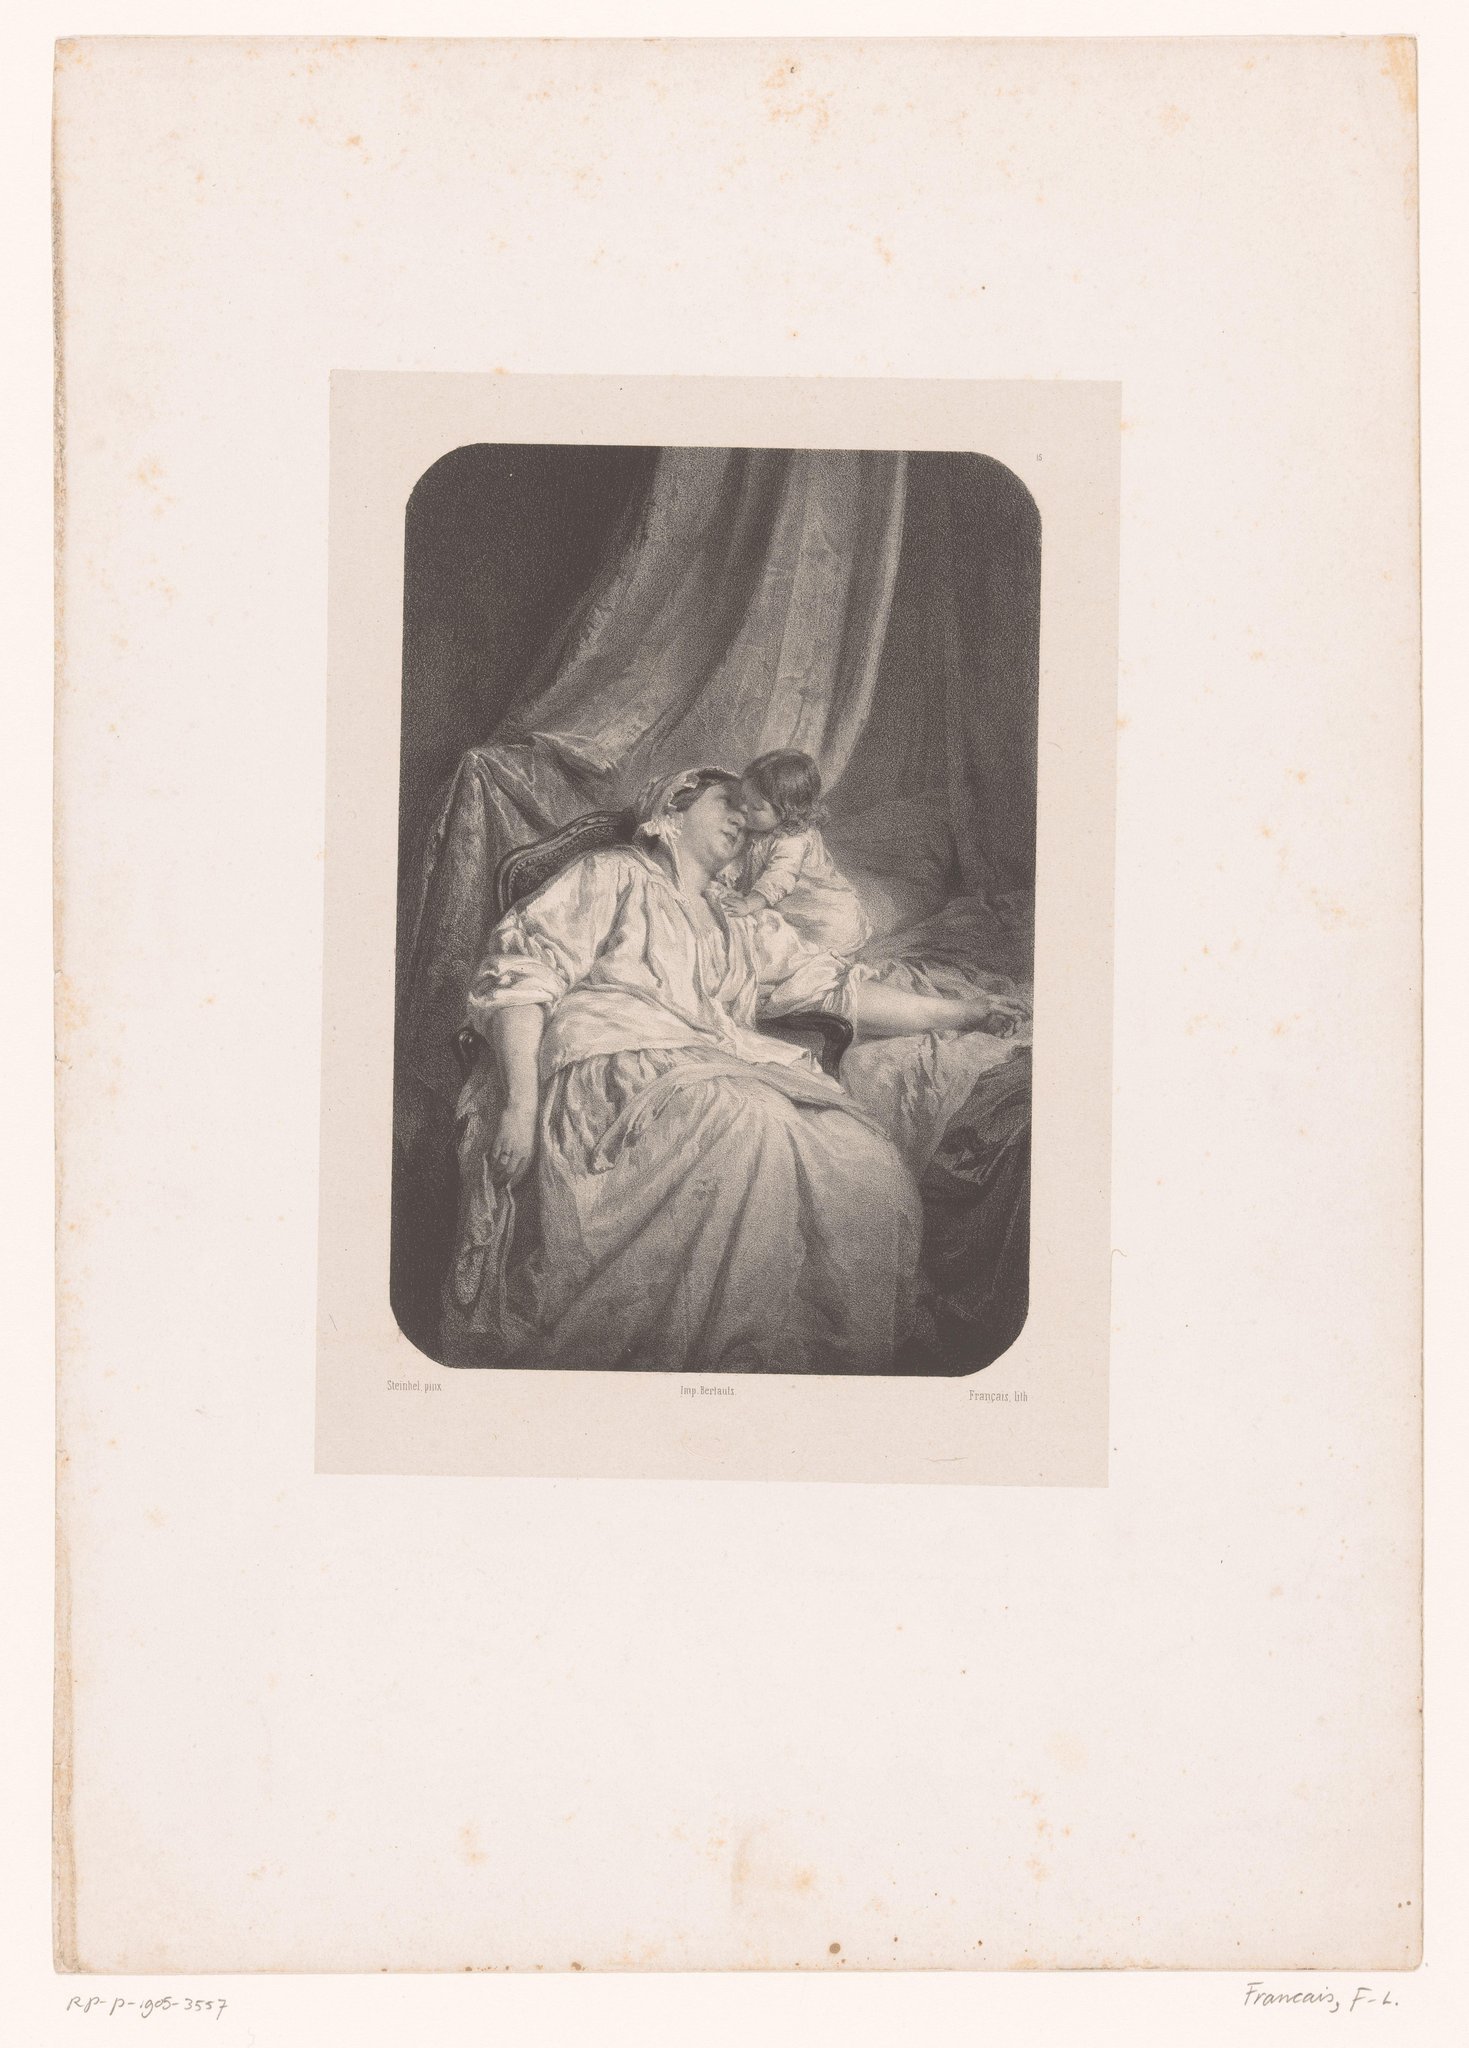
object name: print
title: Moeder met klein kind dat haar kust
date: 1850-1851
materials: paper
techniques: lithograph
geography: paris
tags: embracing each other, kissing, mother and baby or young child, mother and child(ren), woman and child(ren) (family group) (with number of children)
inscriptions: collector's mark: Lugt 2228a, check stamp: Lugt 36a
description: Prent gebruikt voor: Les Artistes anciens et modernes, 1850-1851.